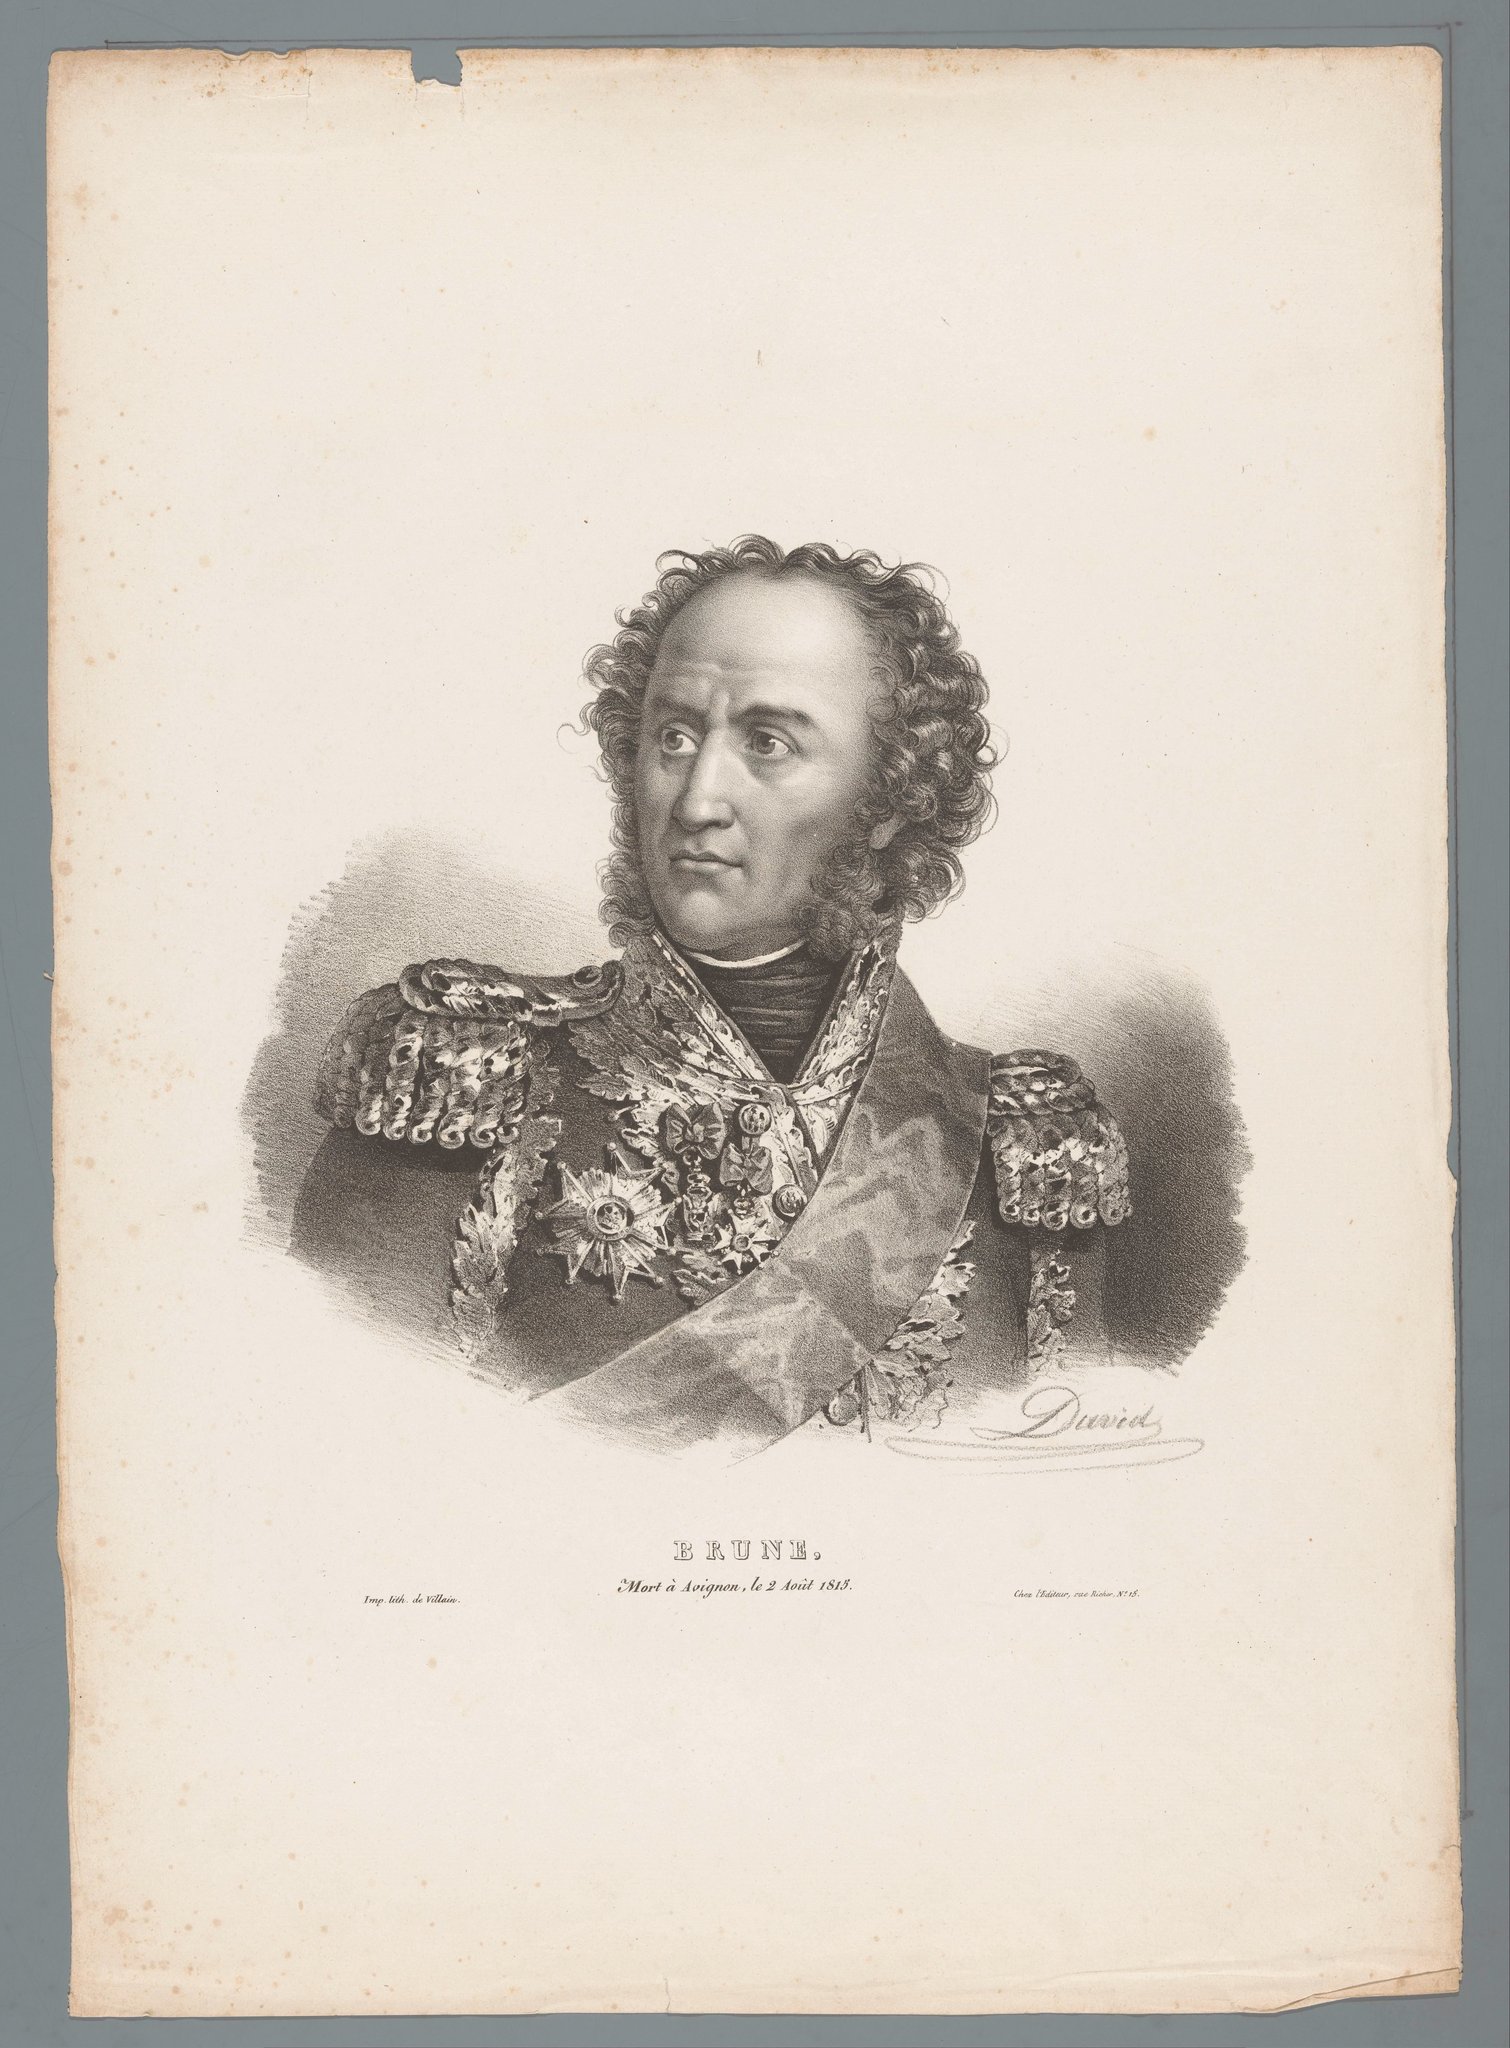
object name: print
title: Portret van maarschalk Guillaume-Marie-Anne Brune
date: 1824-1852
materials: paper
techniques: lithograph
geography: paris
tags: historical persons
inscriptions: collector's mark: Lugt 2228a